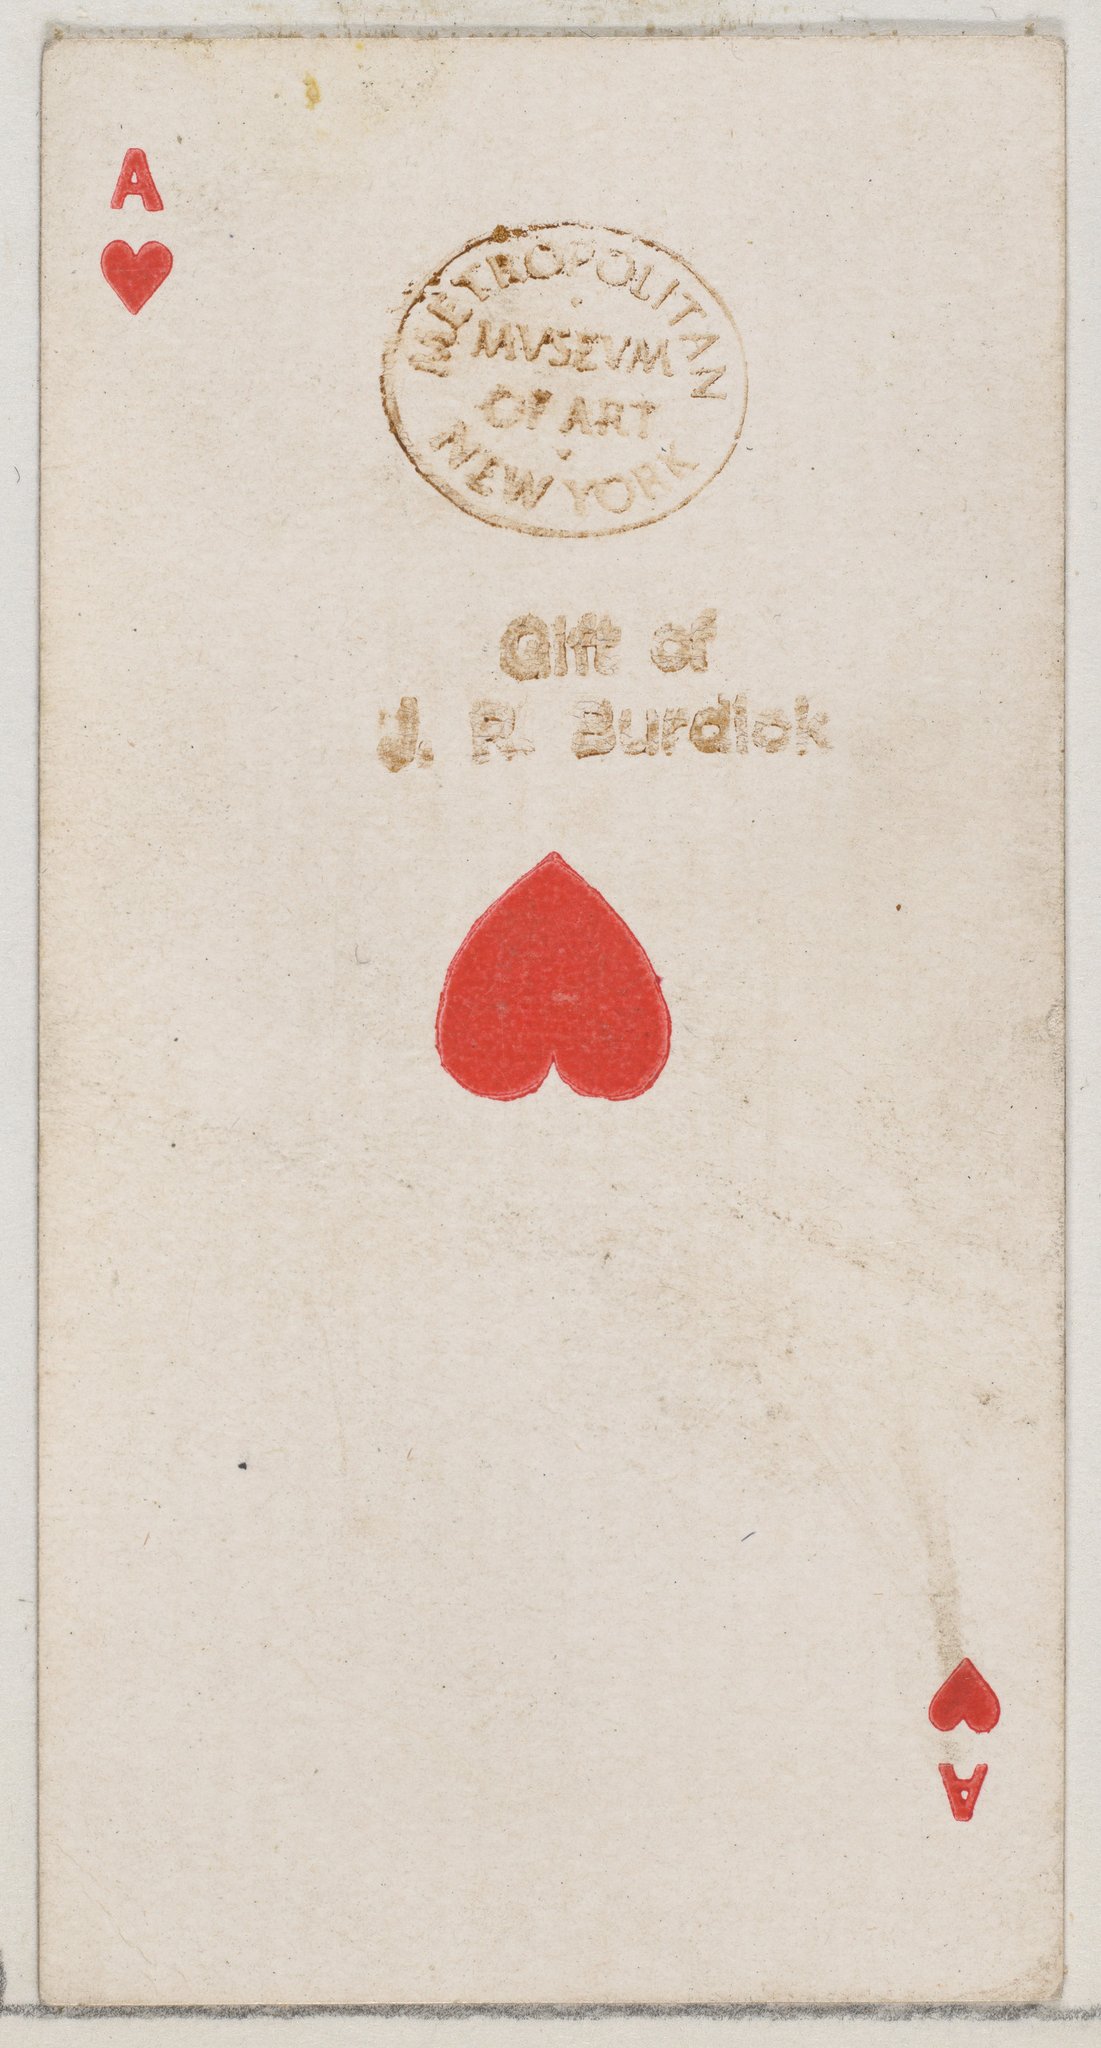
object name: print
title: Ace of Hearts (red), from the Playing Cards series (N84) for Duke brand cigarettes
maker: w. duke, sons & co.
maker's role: publisher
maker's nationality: american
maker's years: 1870-1920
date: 1888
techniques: color lithograph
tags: playing cards